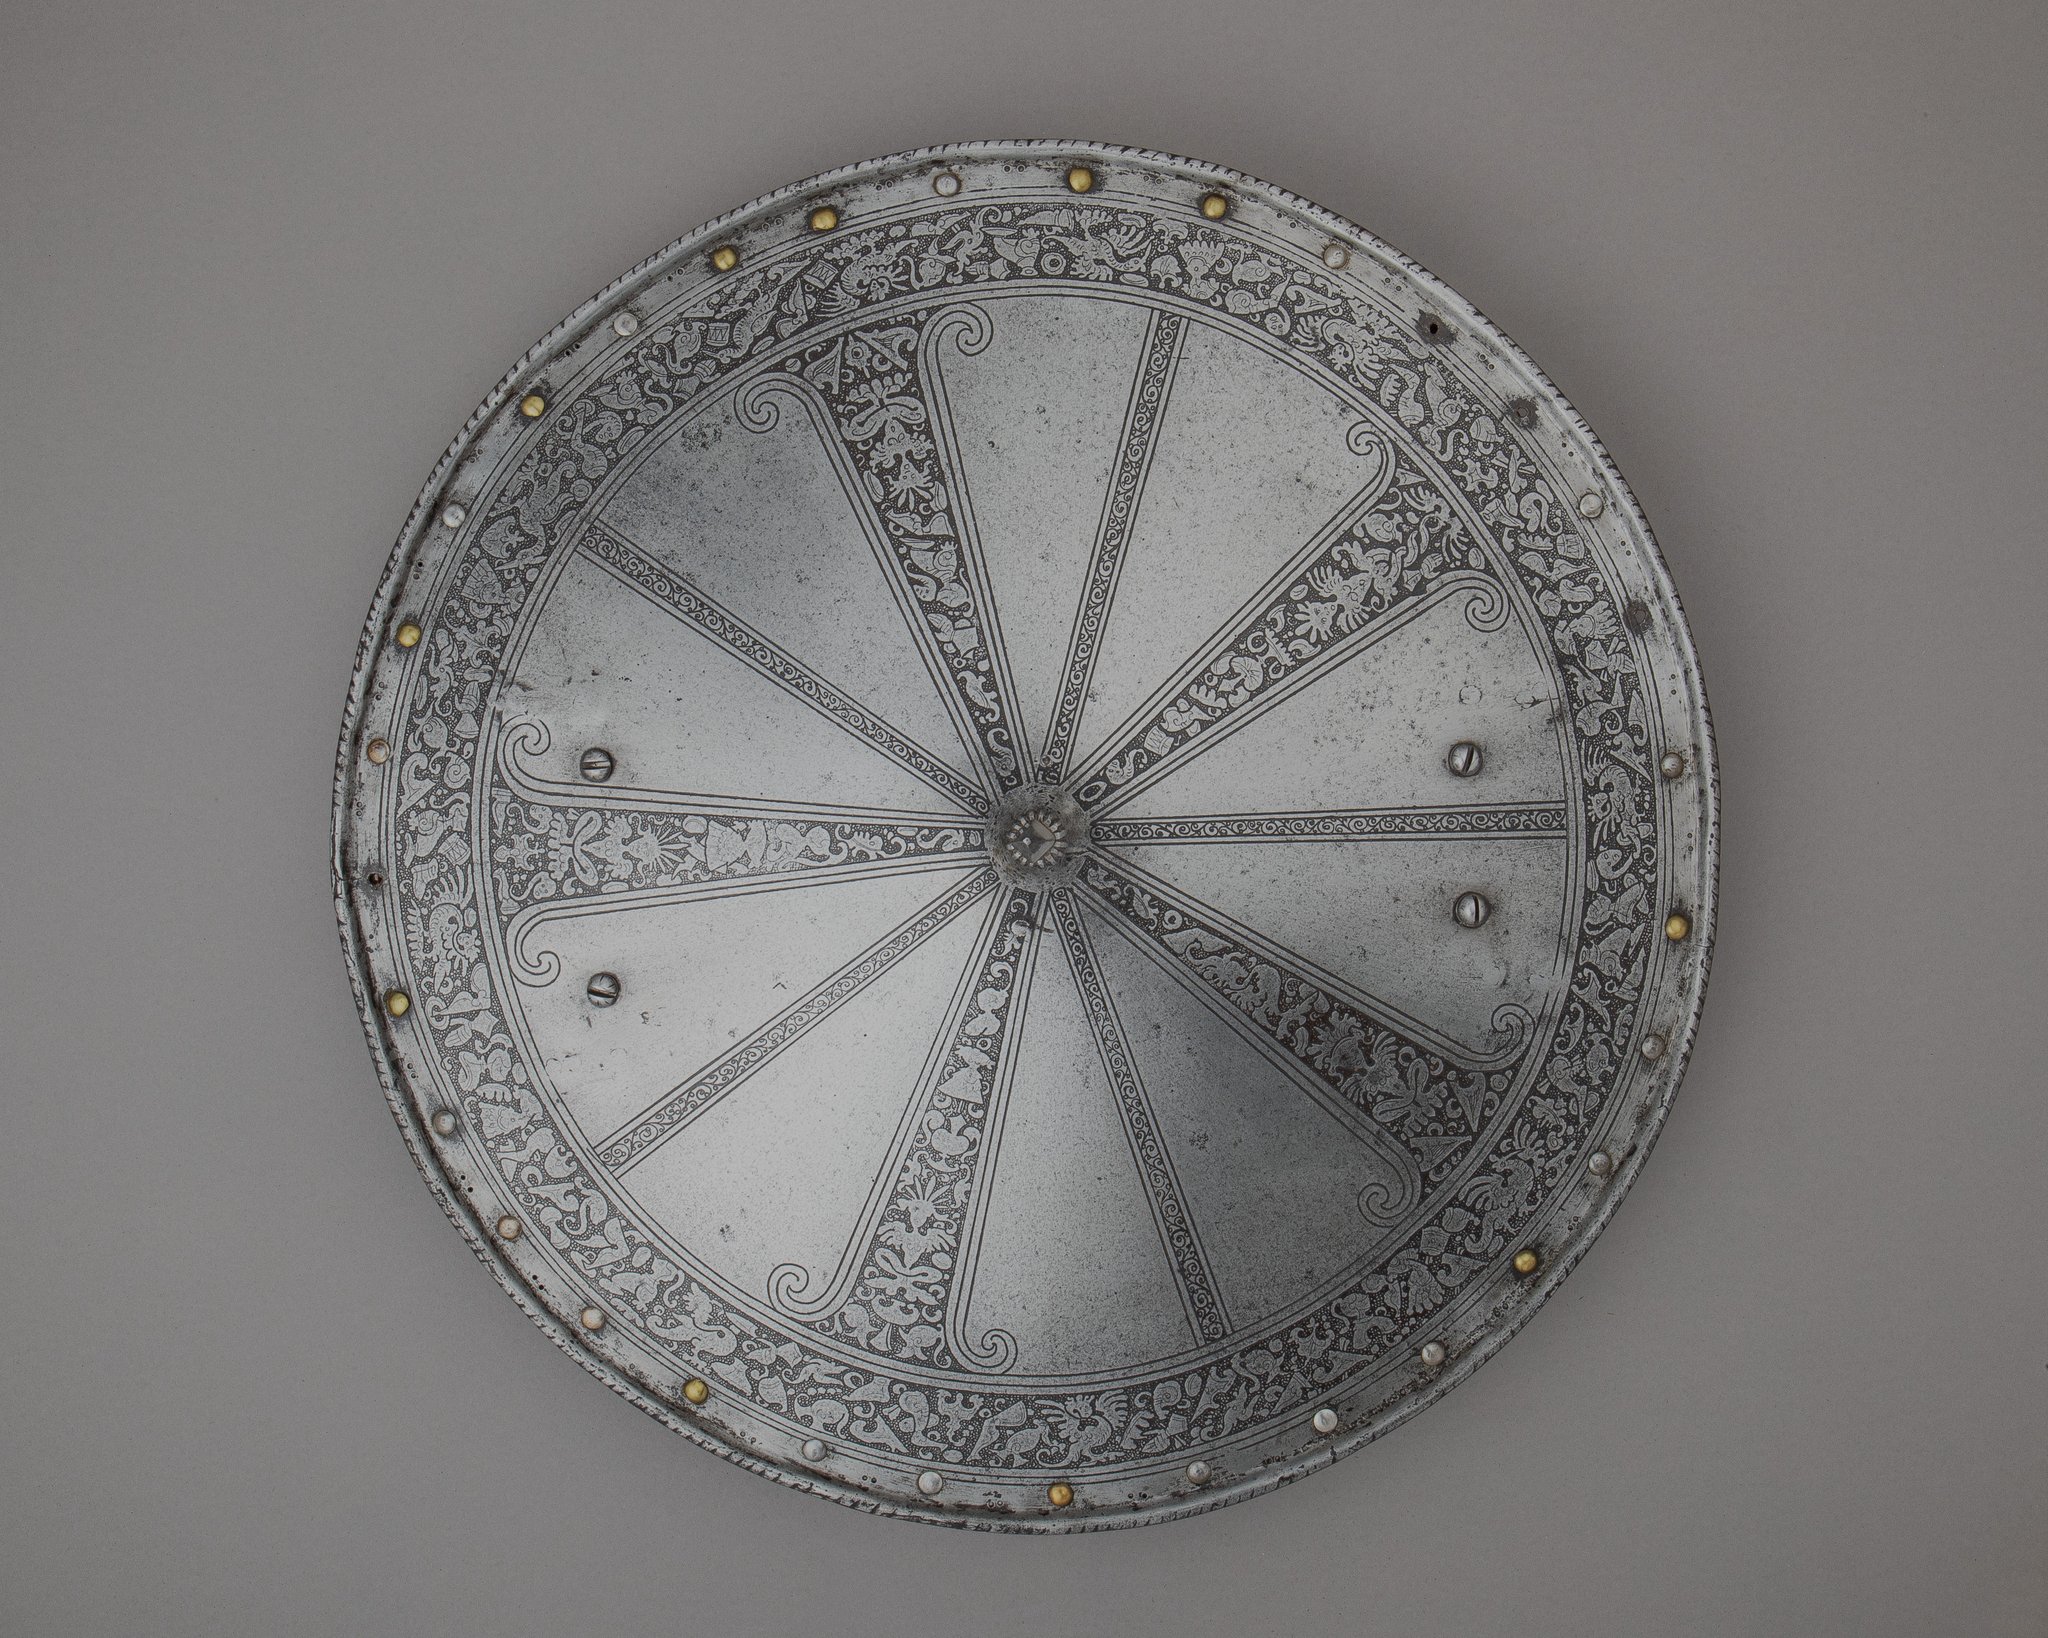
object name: shield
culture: italian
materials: steel, textile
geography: italy